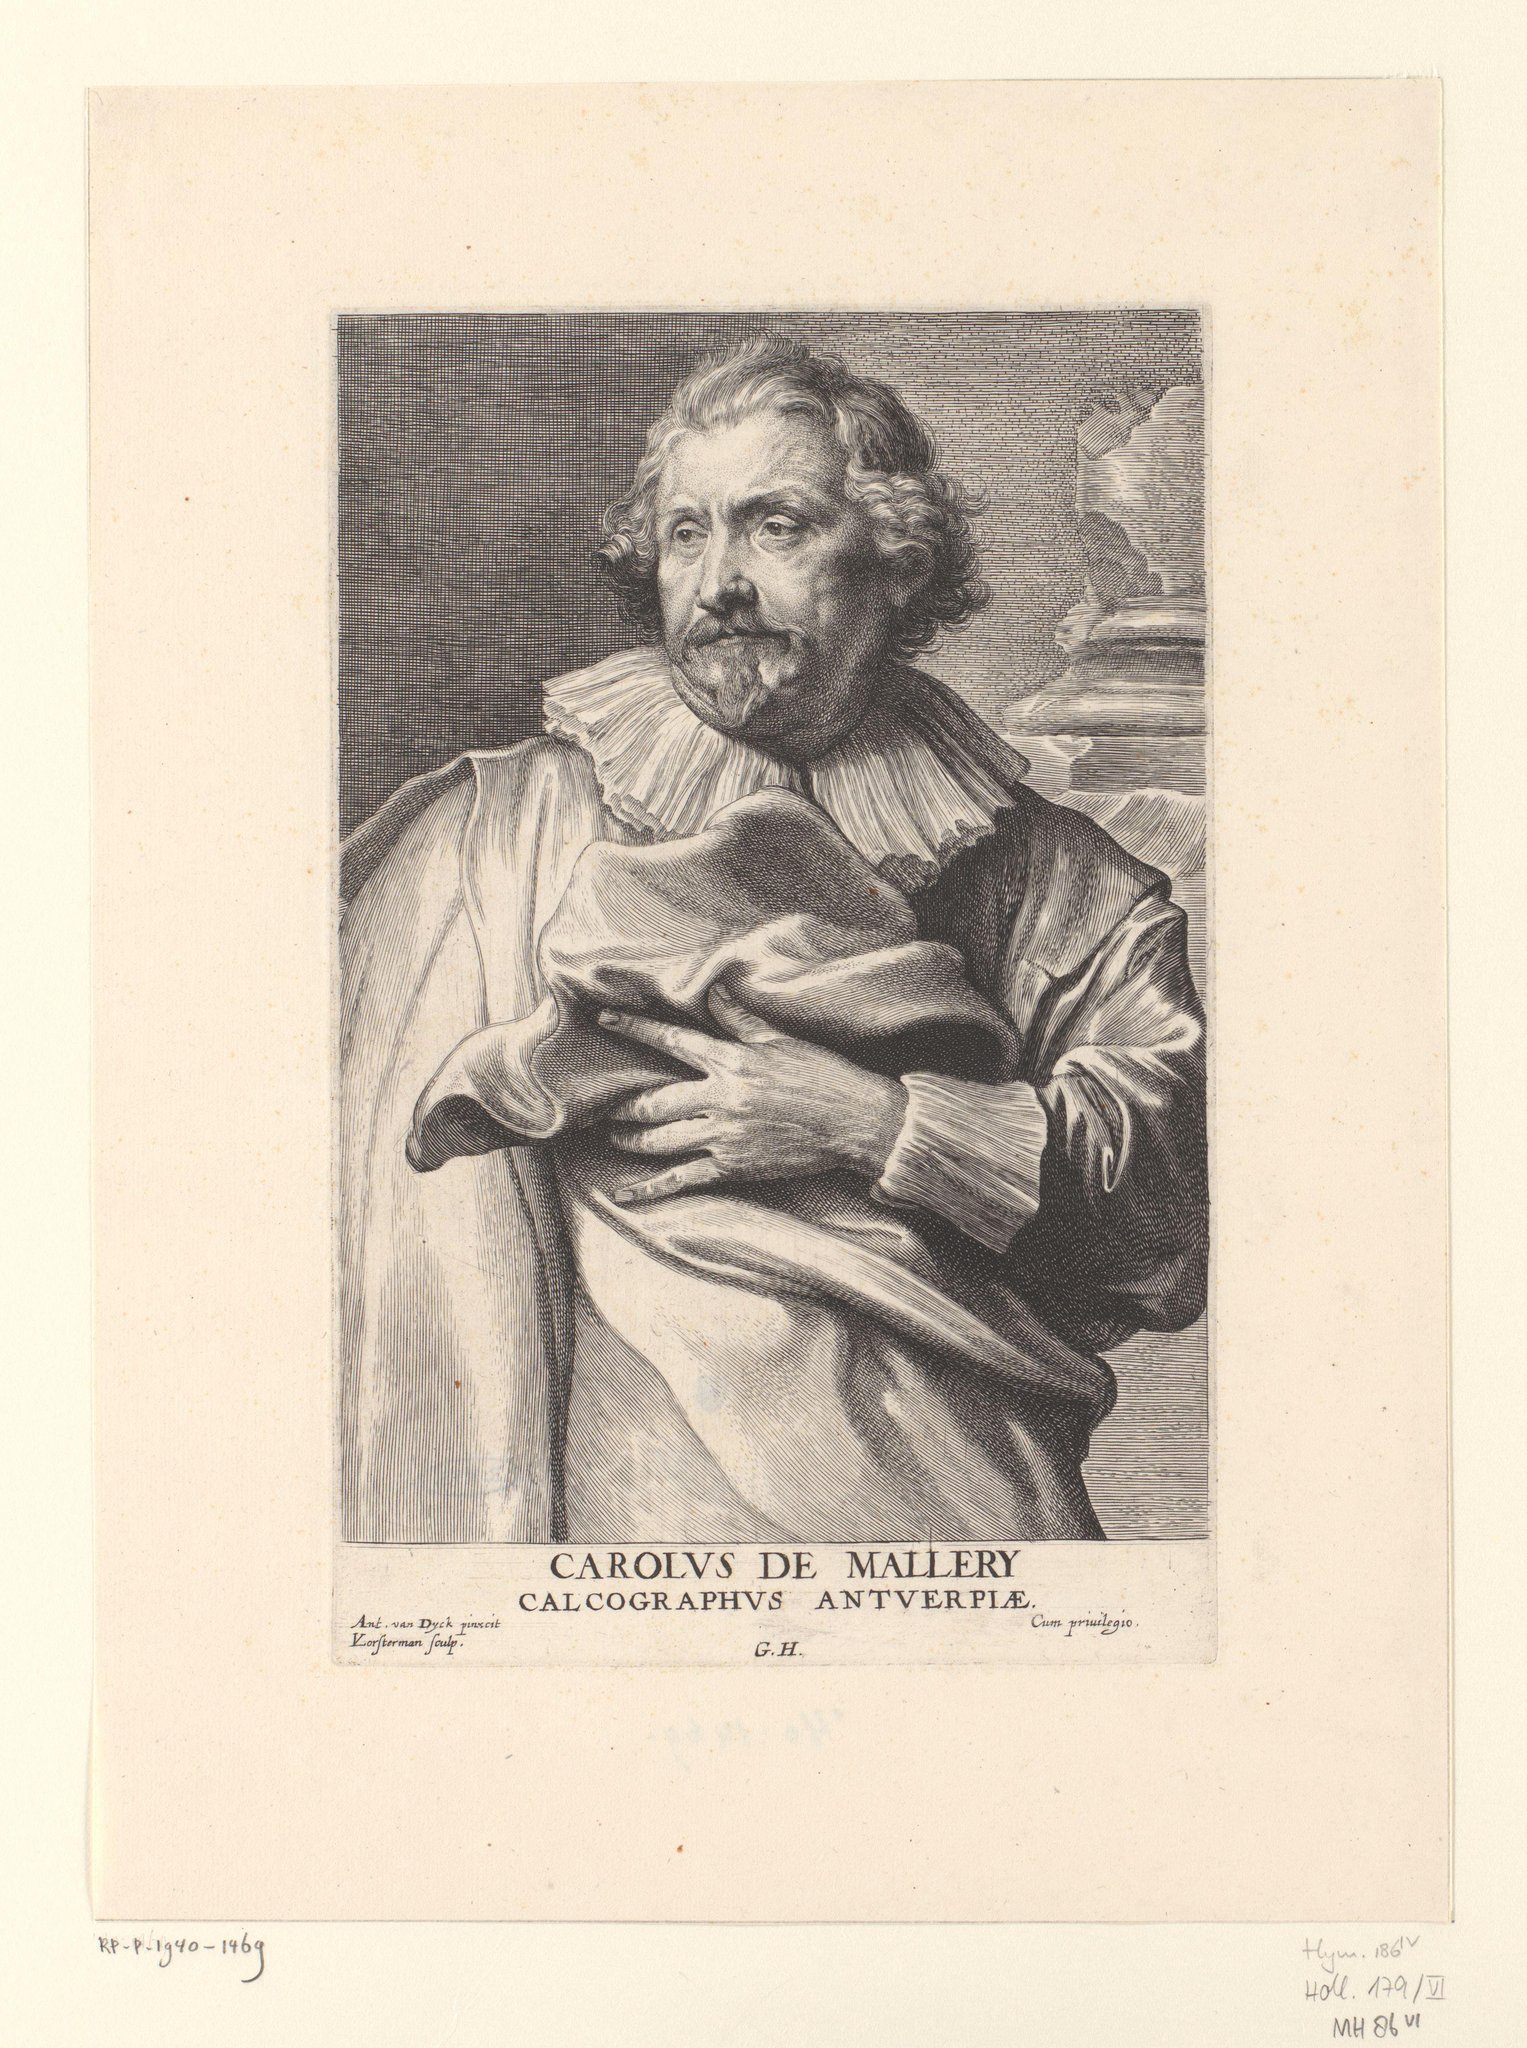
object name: print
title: Portret van Karel van Mallery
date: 1645-1646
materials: paper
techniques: engraving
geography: antwerp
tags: antwerp, karel van mallery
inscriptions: collector's mark: Lugt 2228, collector's mark: Lugt 2760, collector's mark: Lugt 2166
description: Prent gebruikt voor: Icones principum, virorum doctorum, pictorum, chalcographorum, statuariorum nec non amatorum pictoriae artis numero centum ab Ant. van Dyck ad vivum expressae ejusque sumptibus aeri incisae. Antwerpen: Gillis Hendricx, [1645-1646].